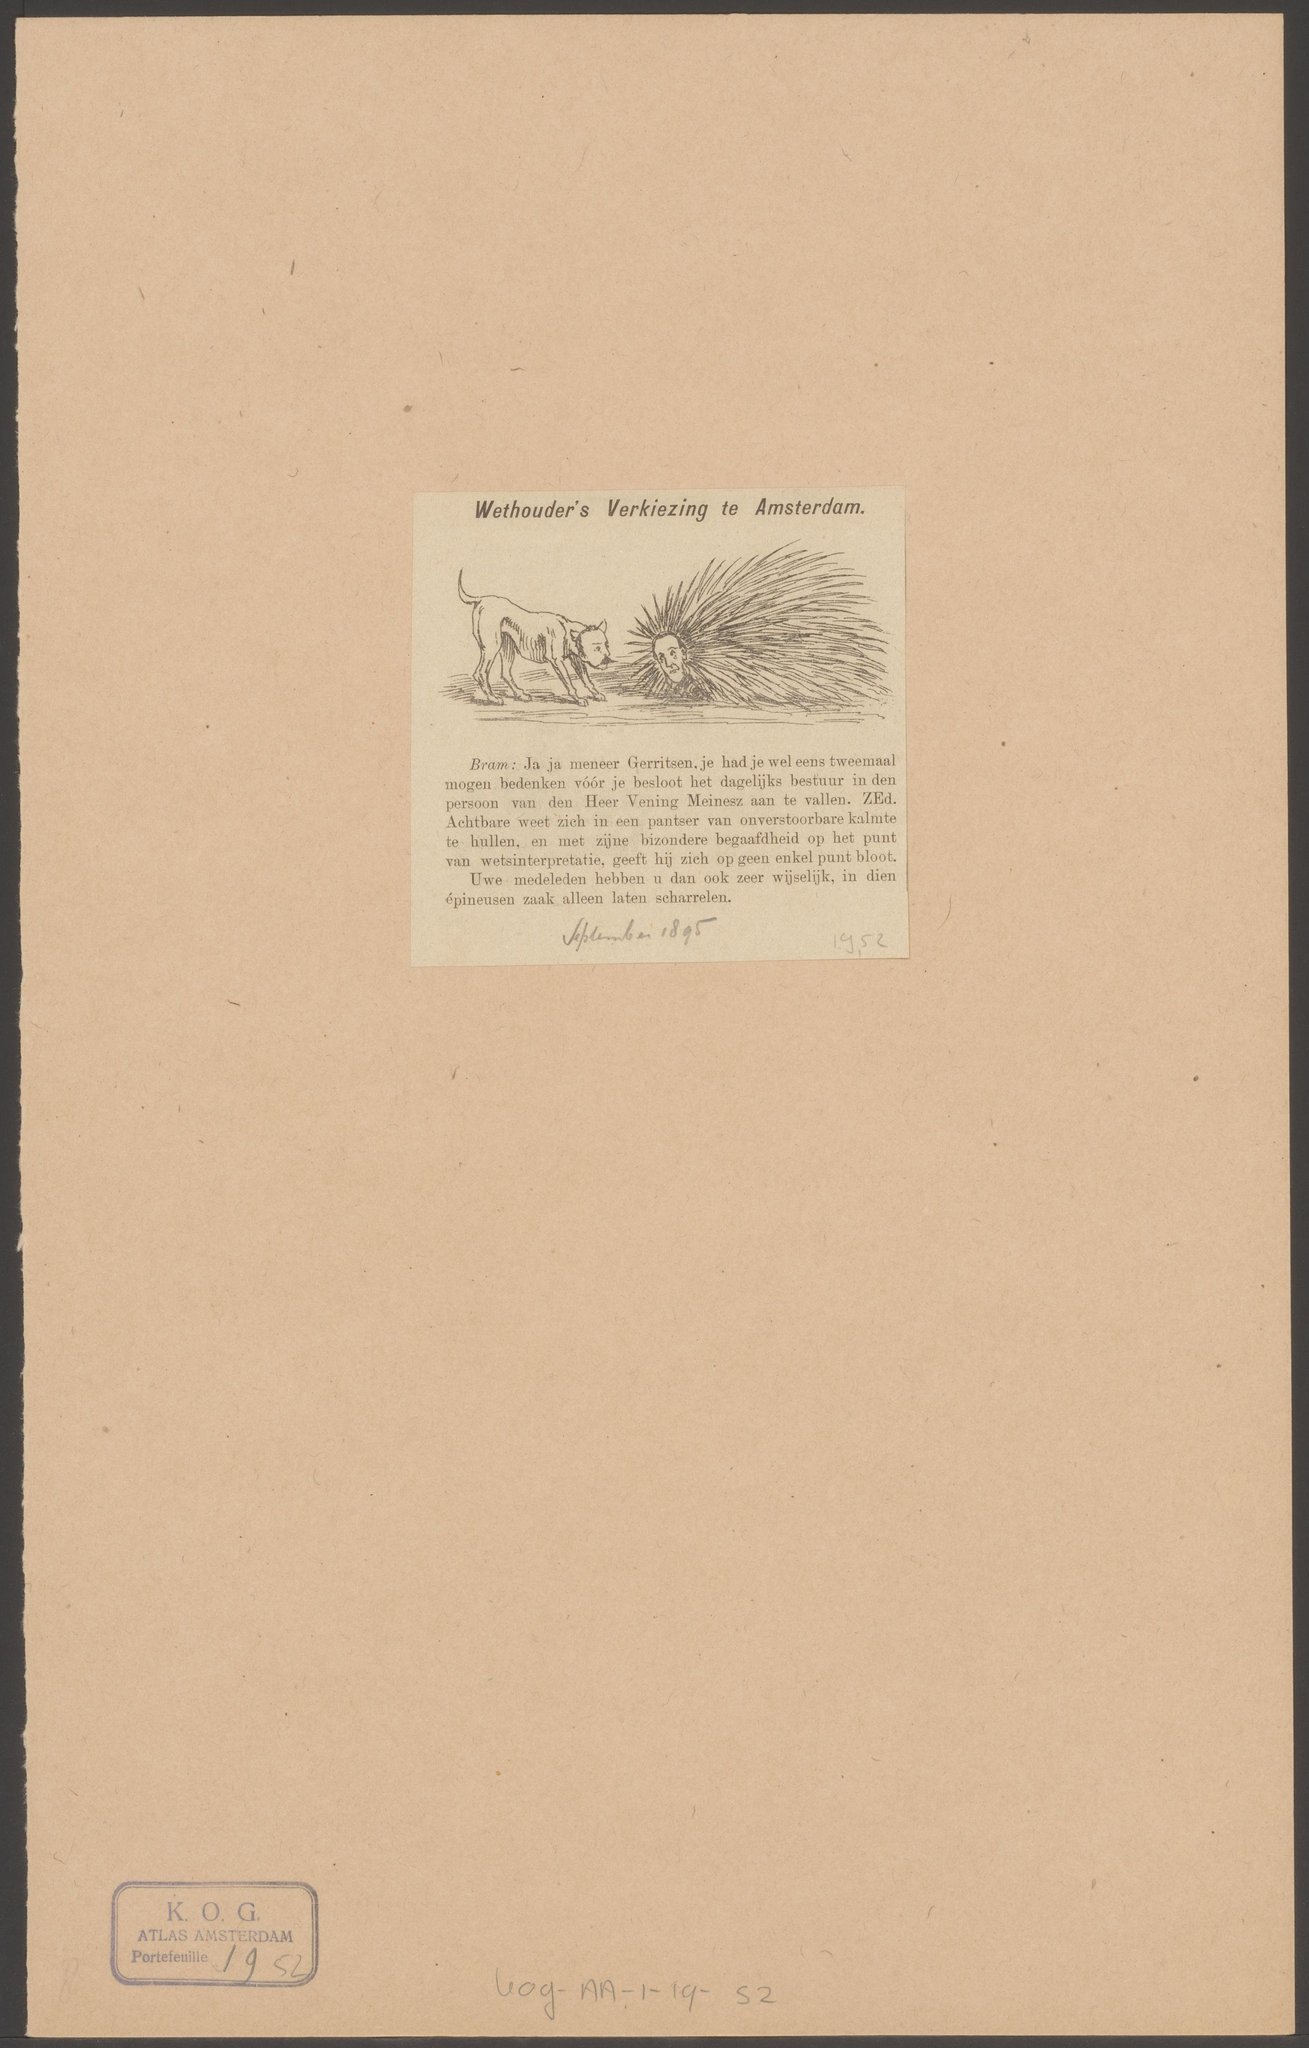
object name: cartoon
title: Spotprent op Sjoerd Vening Meinesz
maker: Anonymous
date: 1809-1895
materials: paper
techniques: letterpress printing, line block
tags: harlingen, politician, mayor, burgomaster, political caricatures and satires, amsterdam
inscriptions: collector's mark: ‘19,52’ Lugt 1641b, date: ‘September 1895’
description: Onderwerpsrubriek binnen de Atlas Amsterdam: Herinneringen aan regeringsleden en hunne huisgezinnen [na 1800].